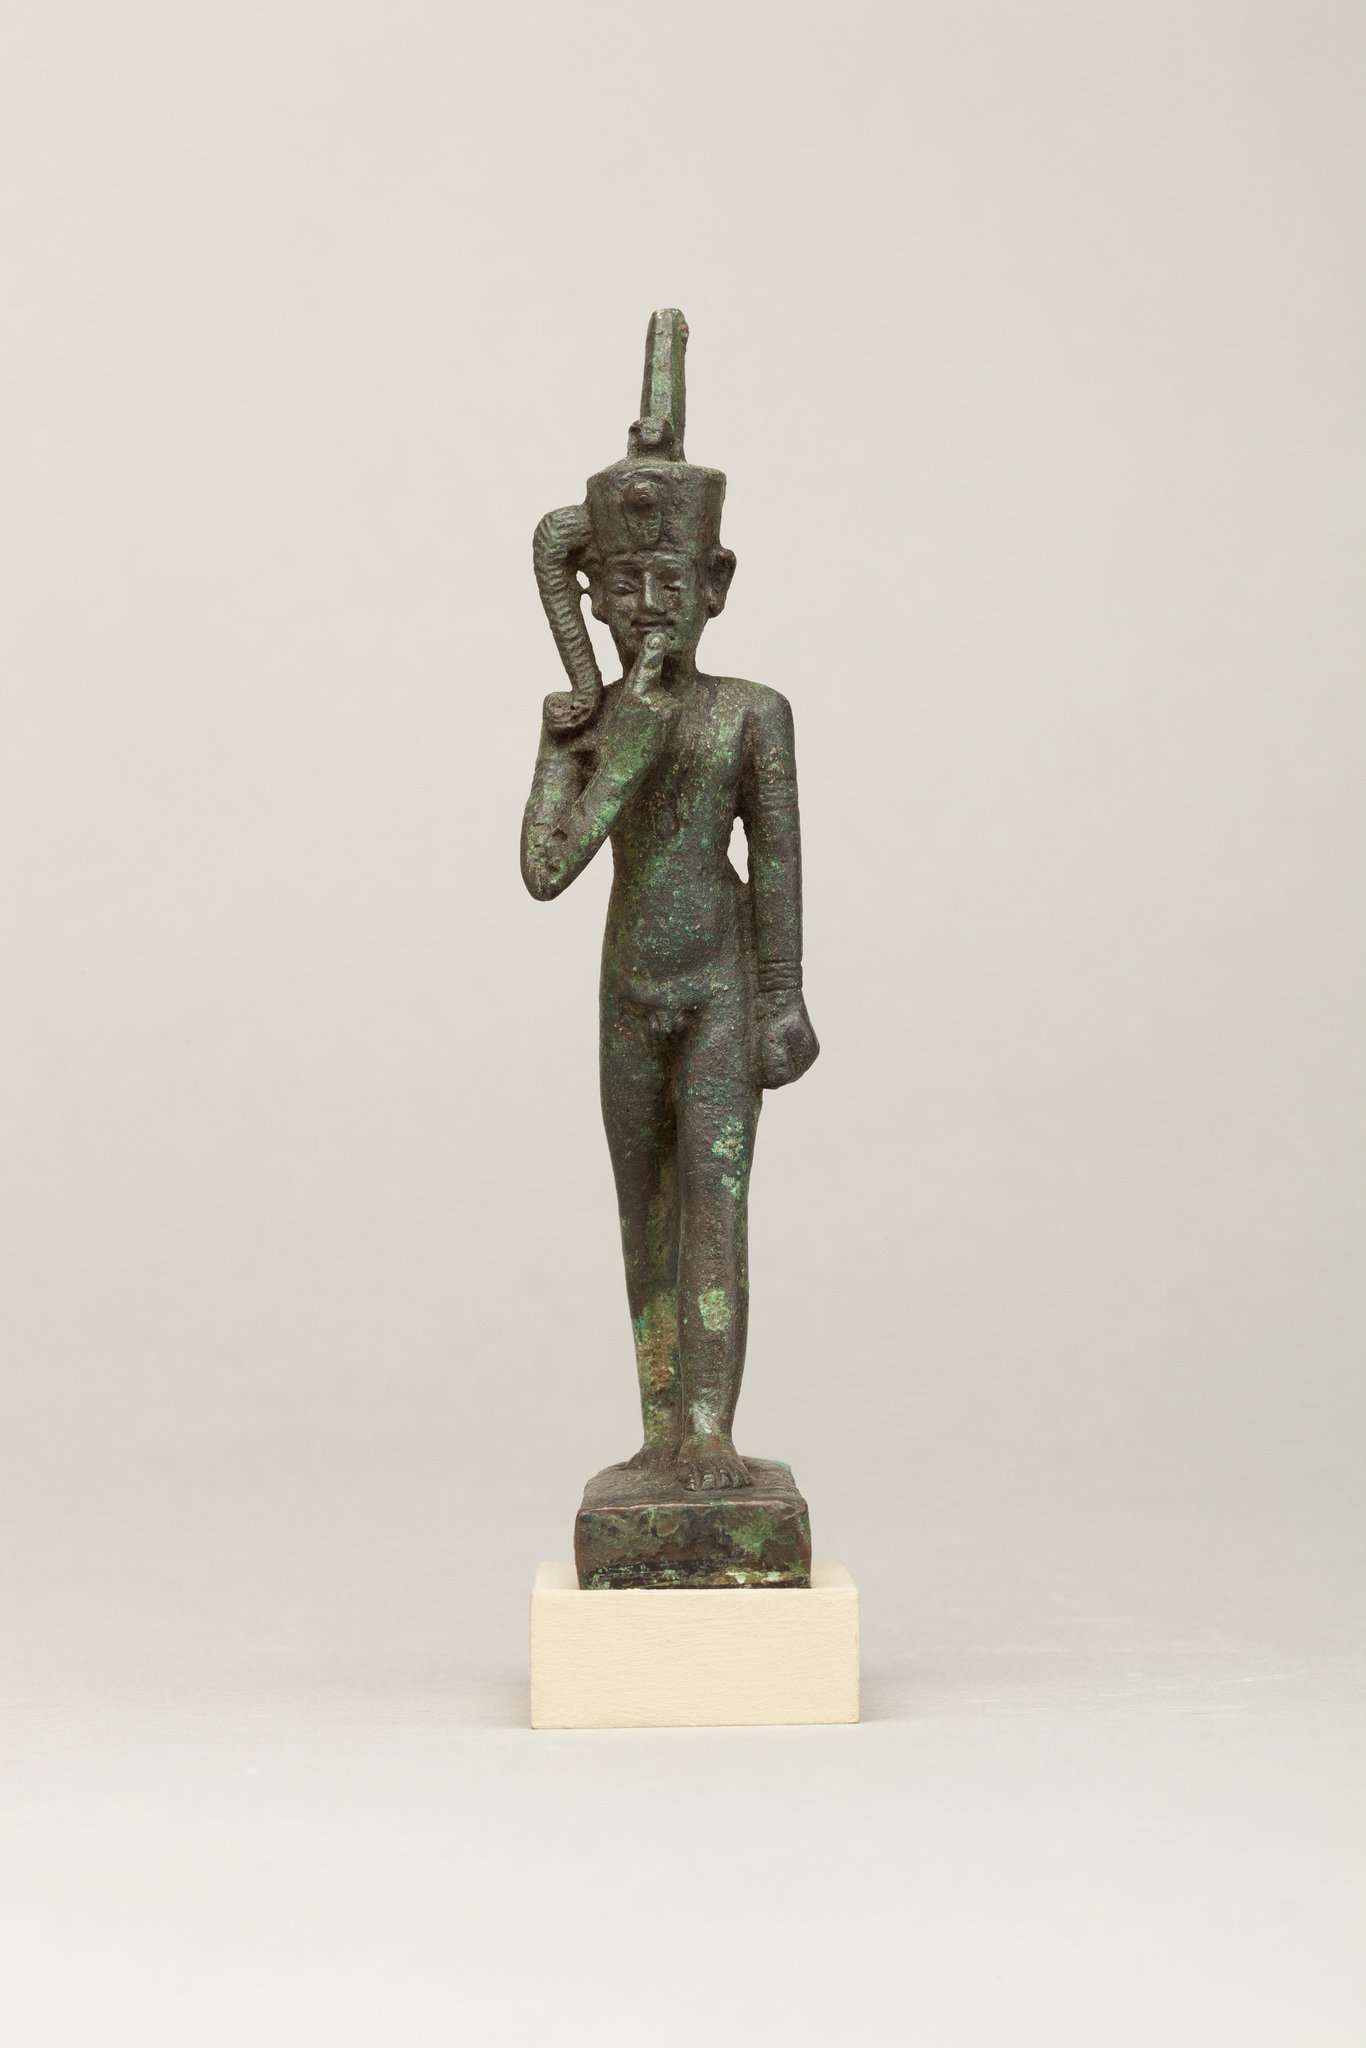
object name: statuette, harpokrates, red crown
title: Harpokrates in red crown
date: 664-630 BCE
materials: metal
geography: egypt